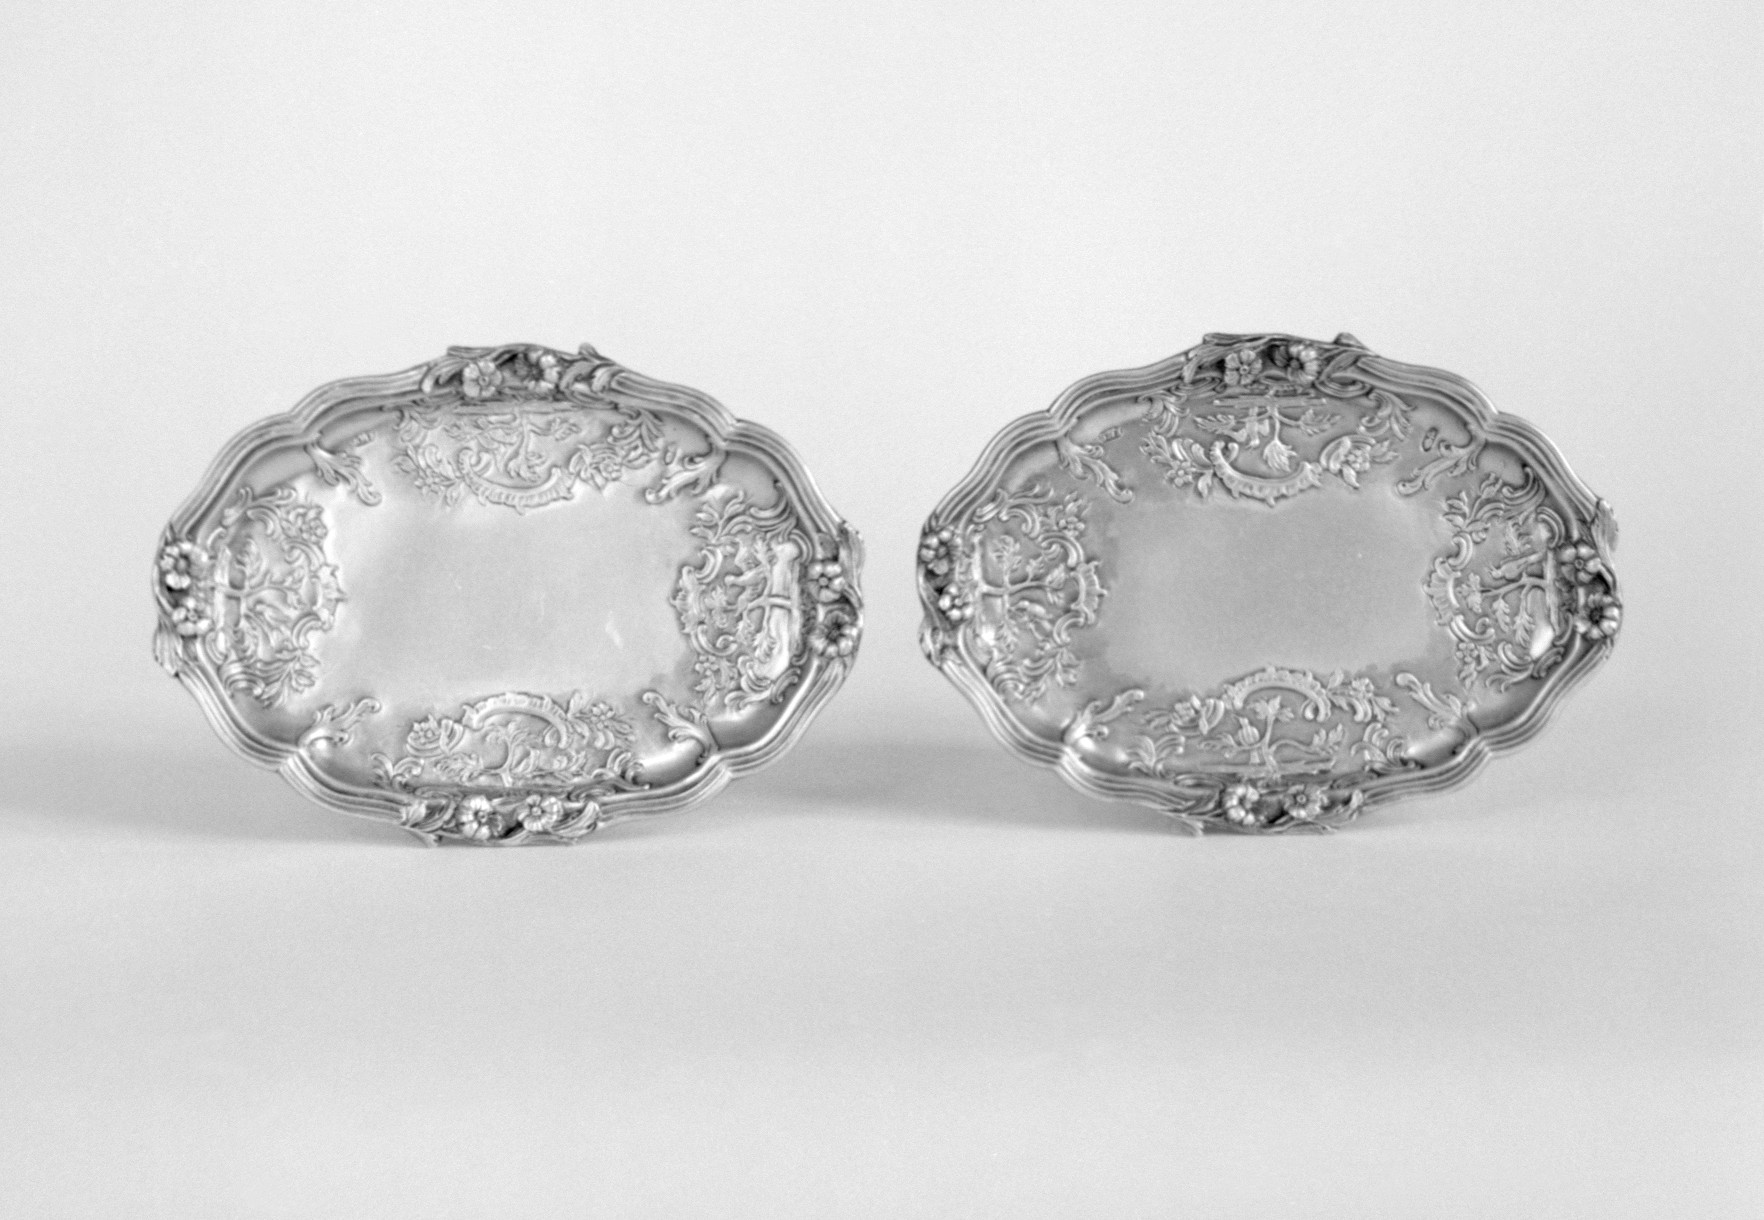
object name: tray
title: Small tray (one of a pair)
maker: johann martin satzger i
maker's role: maker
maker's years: 1707-1785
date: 1761-1763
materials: silver gilt